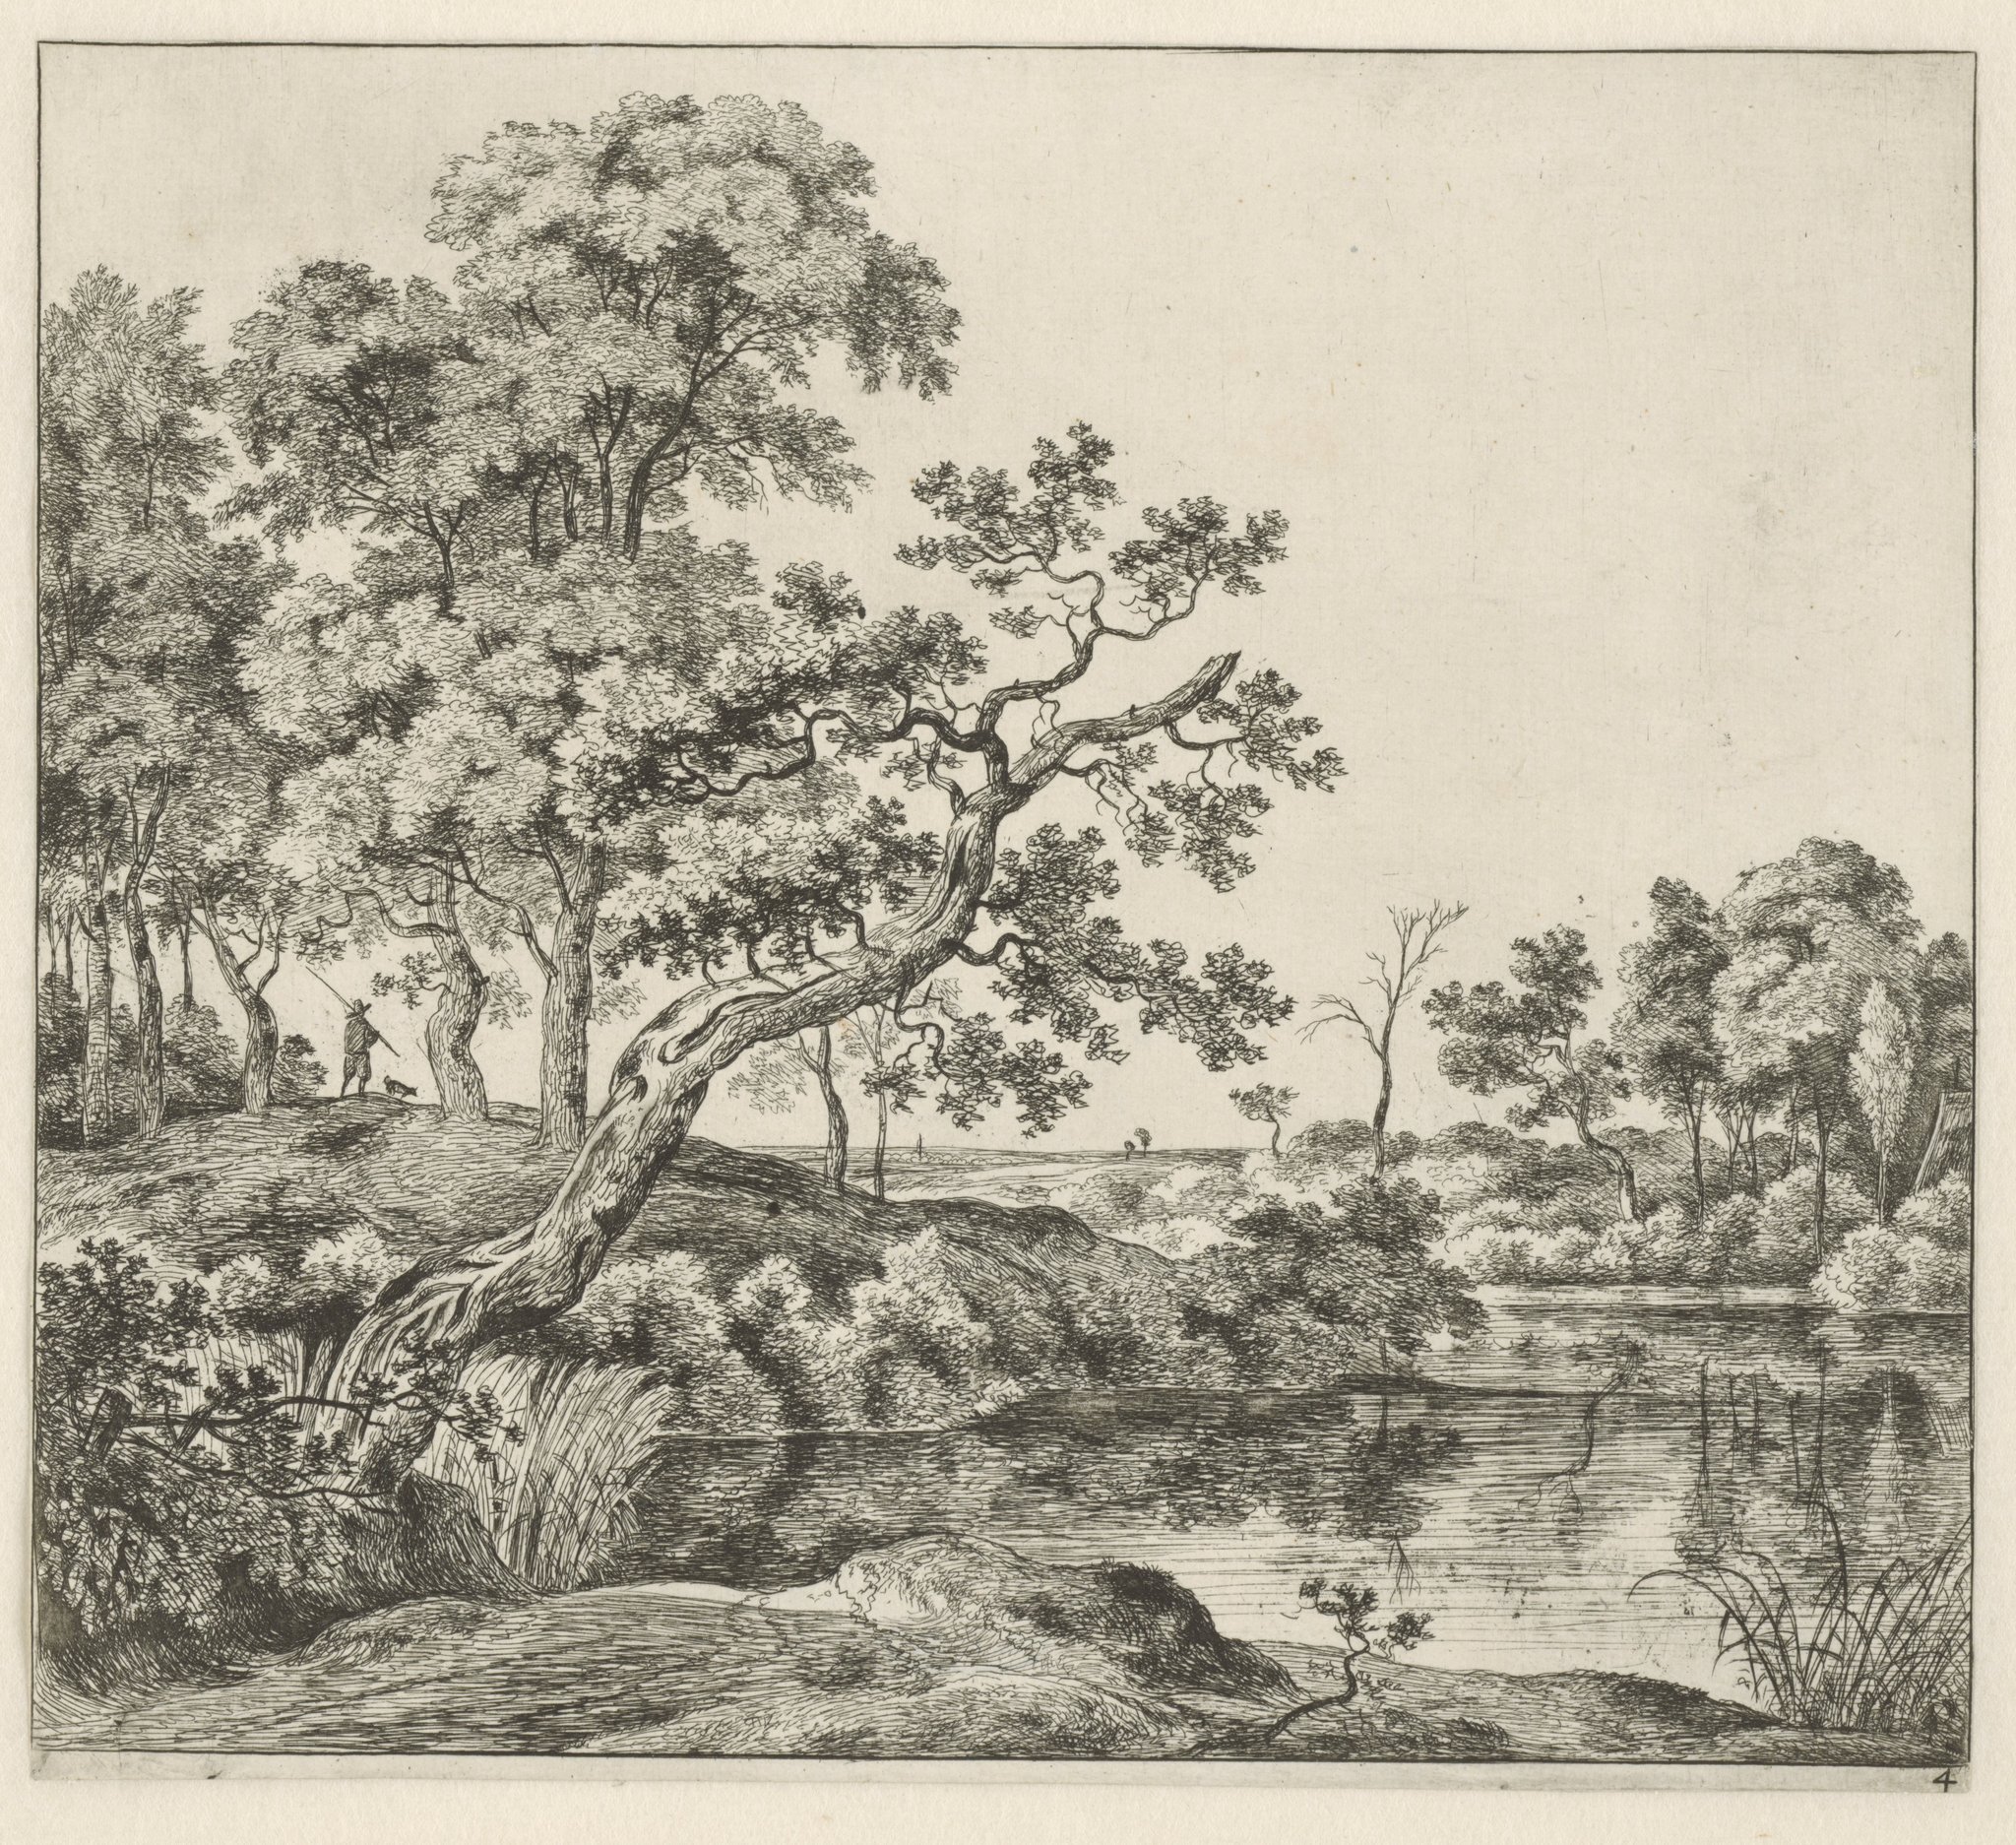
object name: print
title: Vijver aan den rand van een boschrijk landschap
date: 1640-1699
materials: paper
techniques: etching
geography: amsterdam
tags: trees, river bank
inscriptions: collector's mark: Lugt 2228